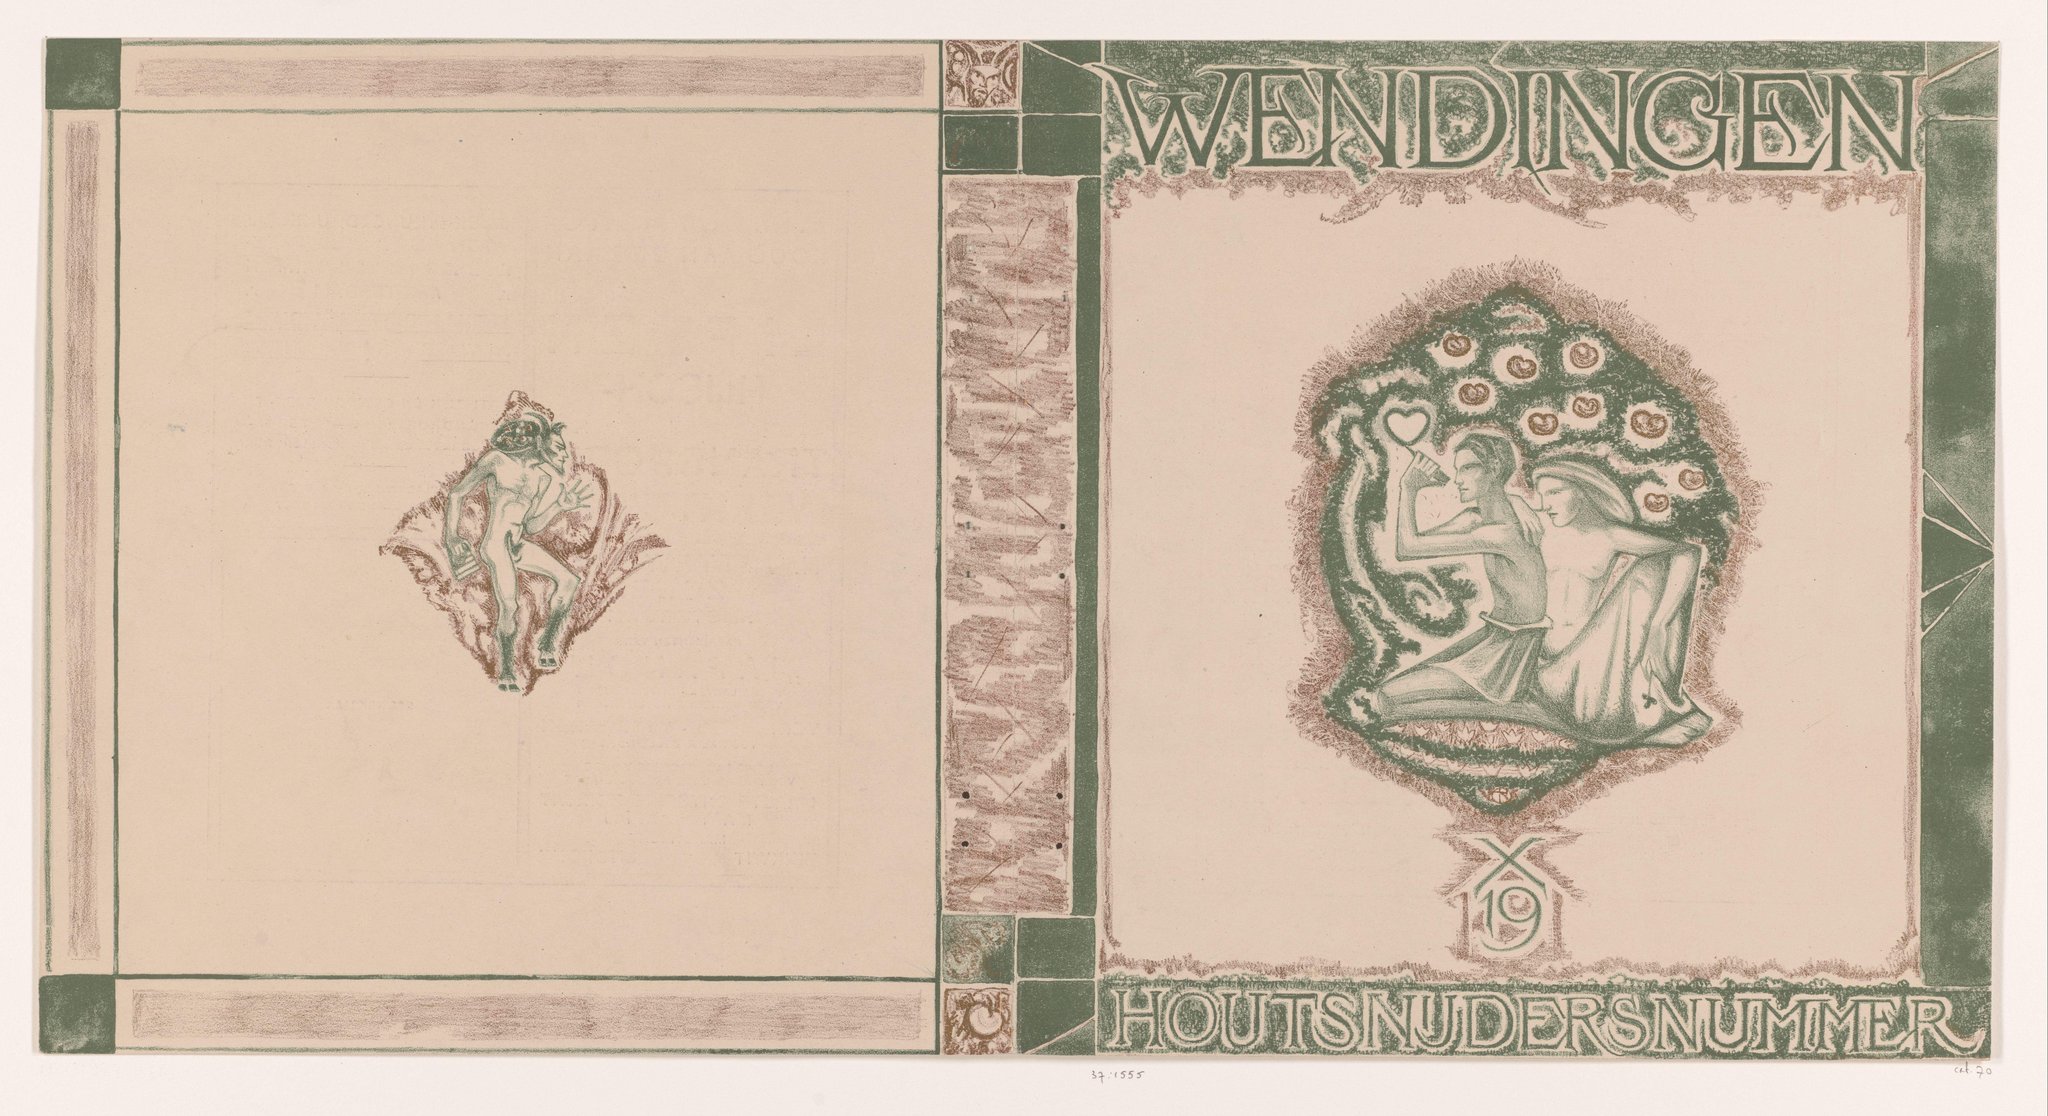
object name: wrapper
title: Omslagontwerp voor: Wendingen, Houtsnijdersnummer, 1919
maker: richard nicolaüs roland holst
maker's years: 1868-1938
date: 1919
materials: paper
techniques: lithograph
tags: fruit-tree culture; fruit harvest, satyr(s) (in general), wood carver, carving heart and initials in an object, e.g. a tree trunk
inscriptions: collector's mark: Lugt 2228, collector's mark: Lugt 2760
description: Links een sater in een bos. Rechts een halfnaakte man en een vrouw, zittend bij een fruitboom. De man kerft een hart in de stam van de boom. De vrouw houdt een klaver vast in haar hand. Op verso advertenties.